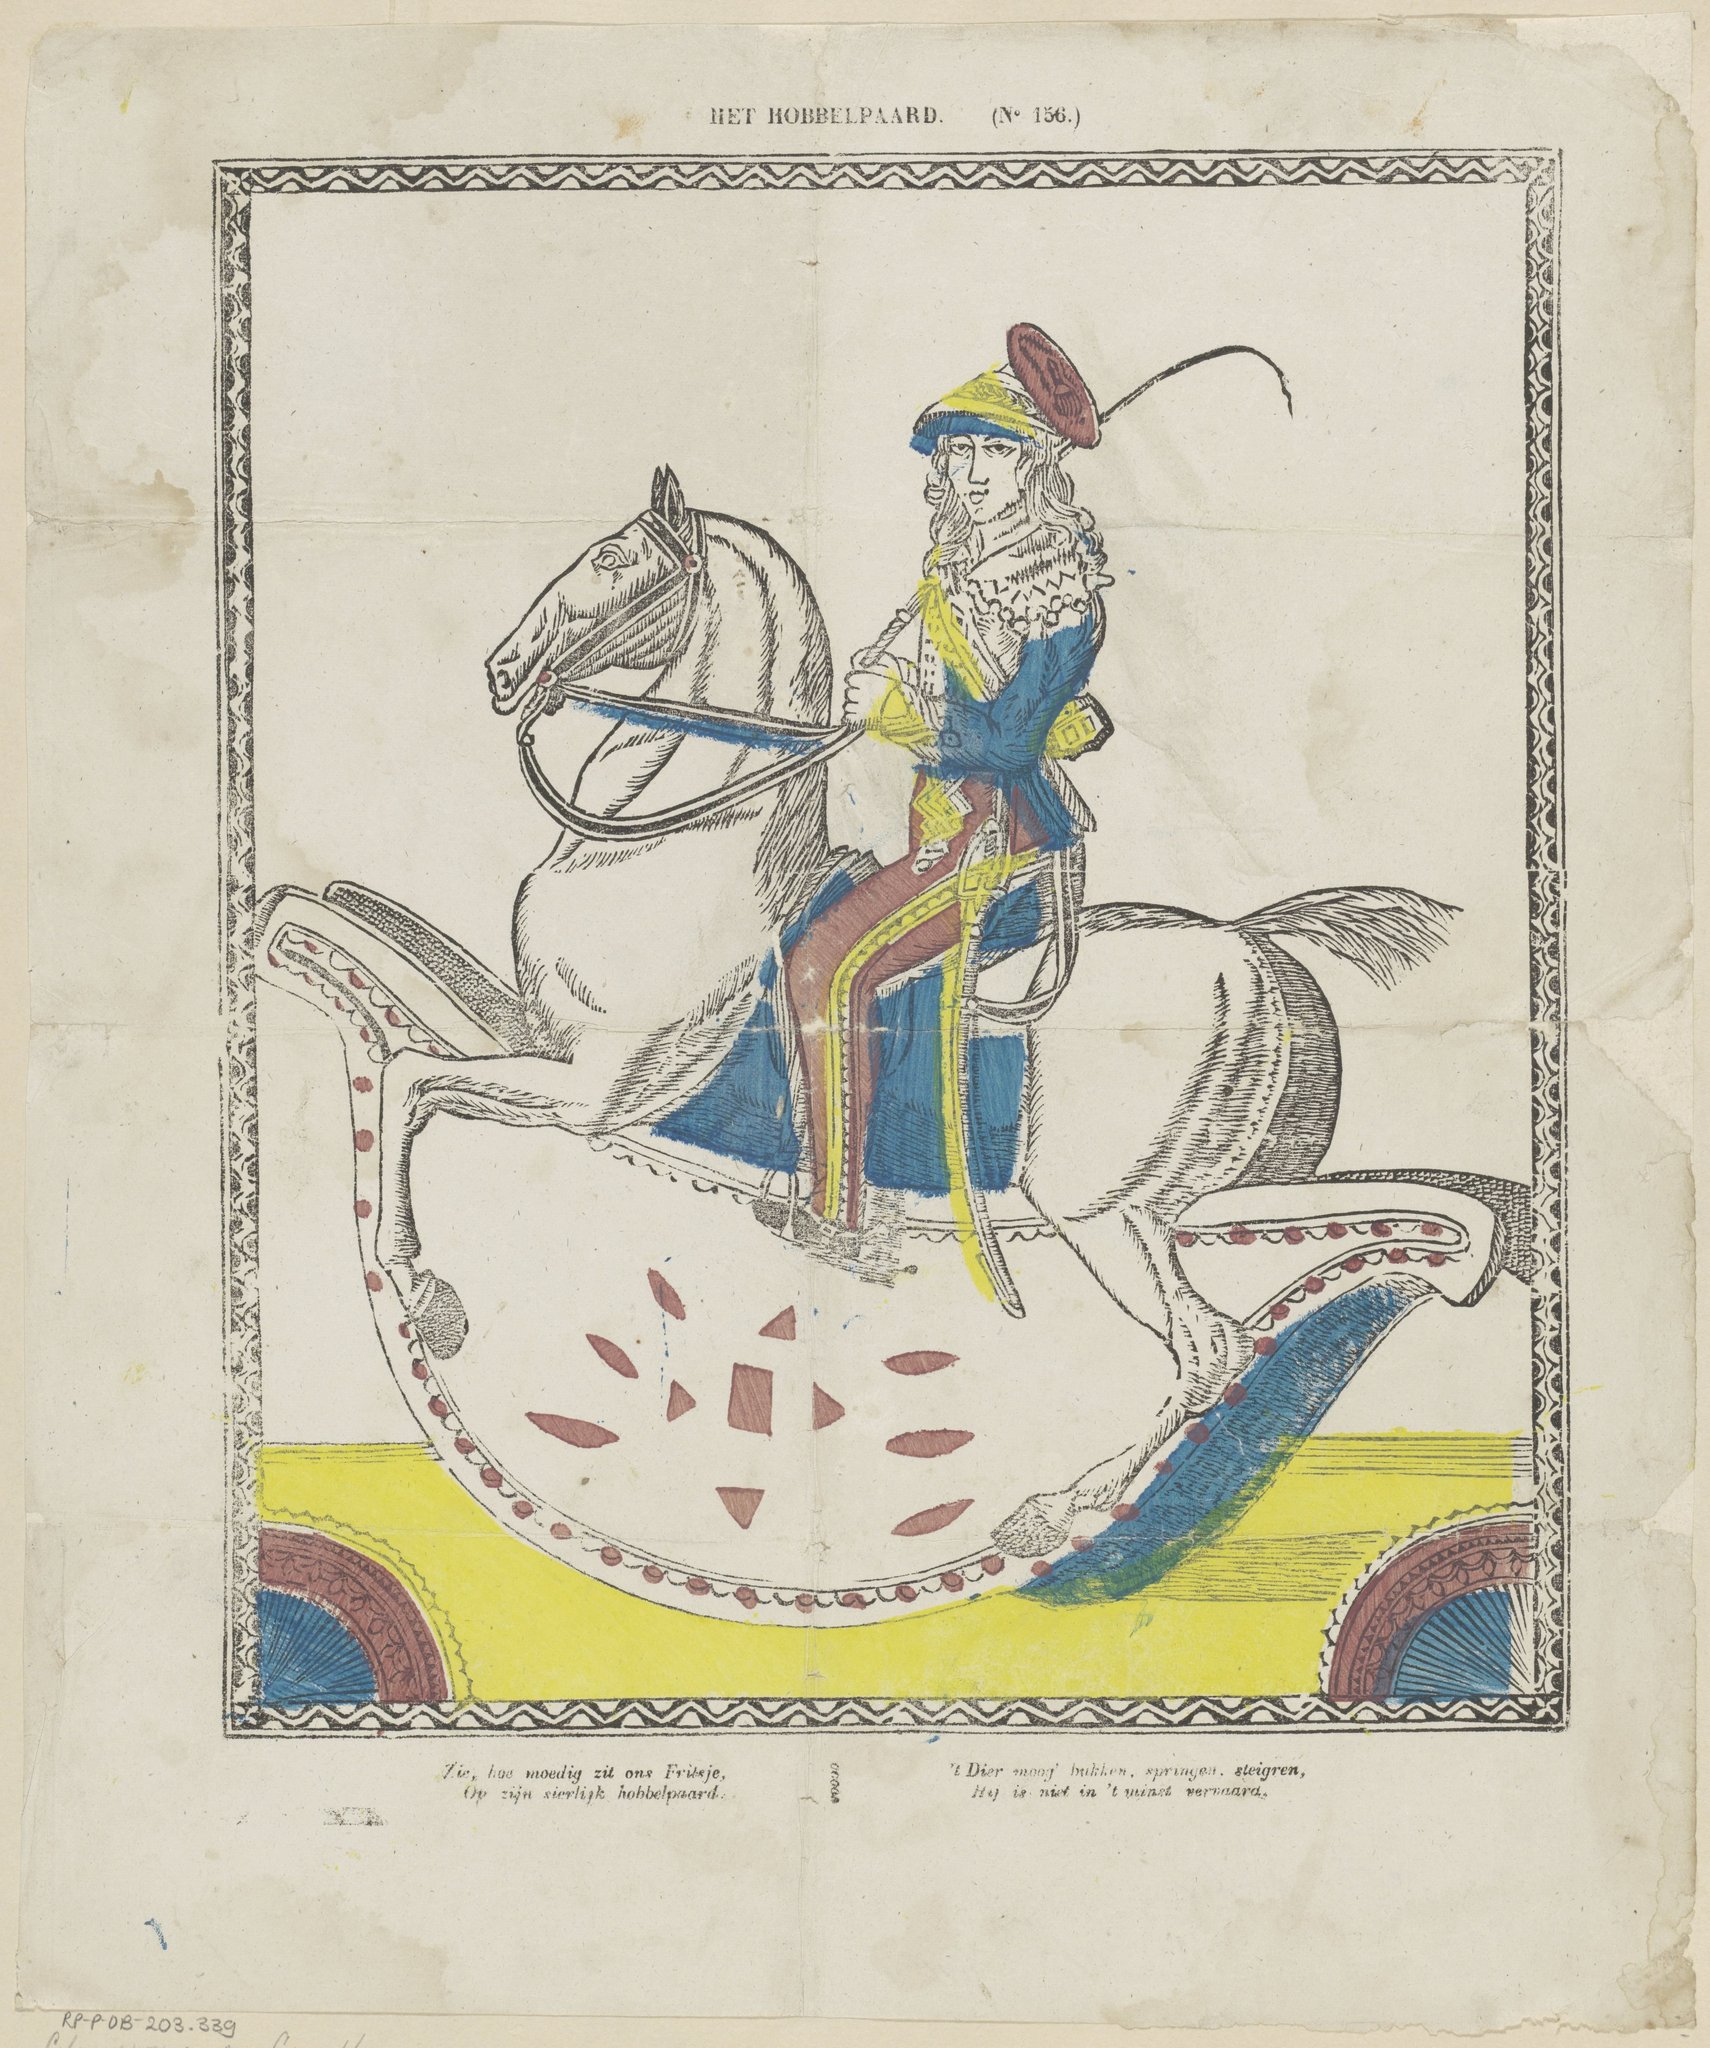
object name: popular print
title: Het hobbelpaard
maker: Anonymous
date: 1833-1856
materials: paper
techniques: colour, letterpress printing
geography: turnhout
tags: rocking-horse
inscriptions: collector's mark: Lugt 2760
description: Blad met een grote voorstelling van een jongen op een hobbelpaard. Geheel omgeven door een sierrand. In de ondermarge een vierregelig vers in twee kolommen. Genummerd midden boven: (No 156).